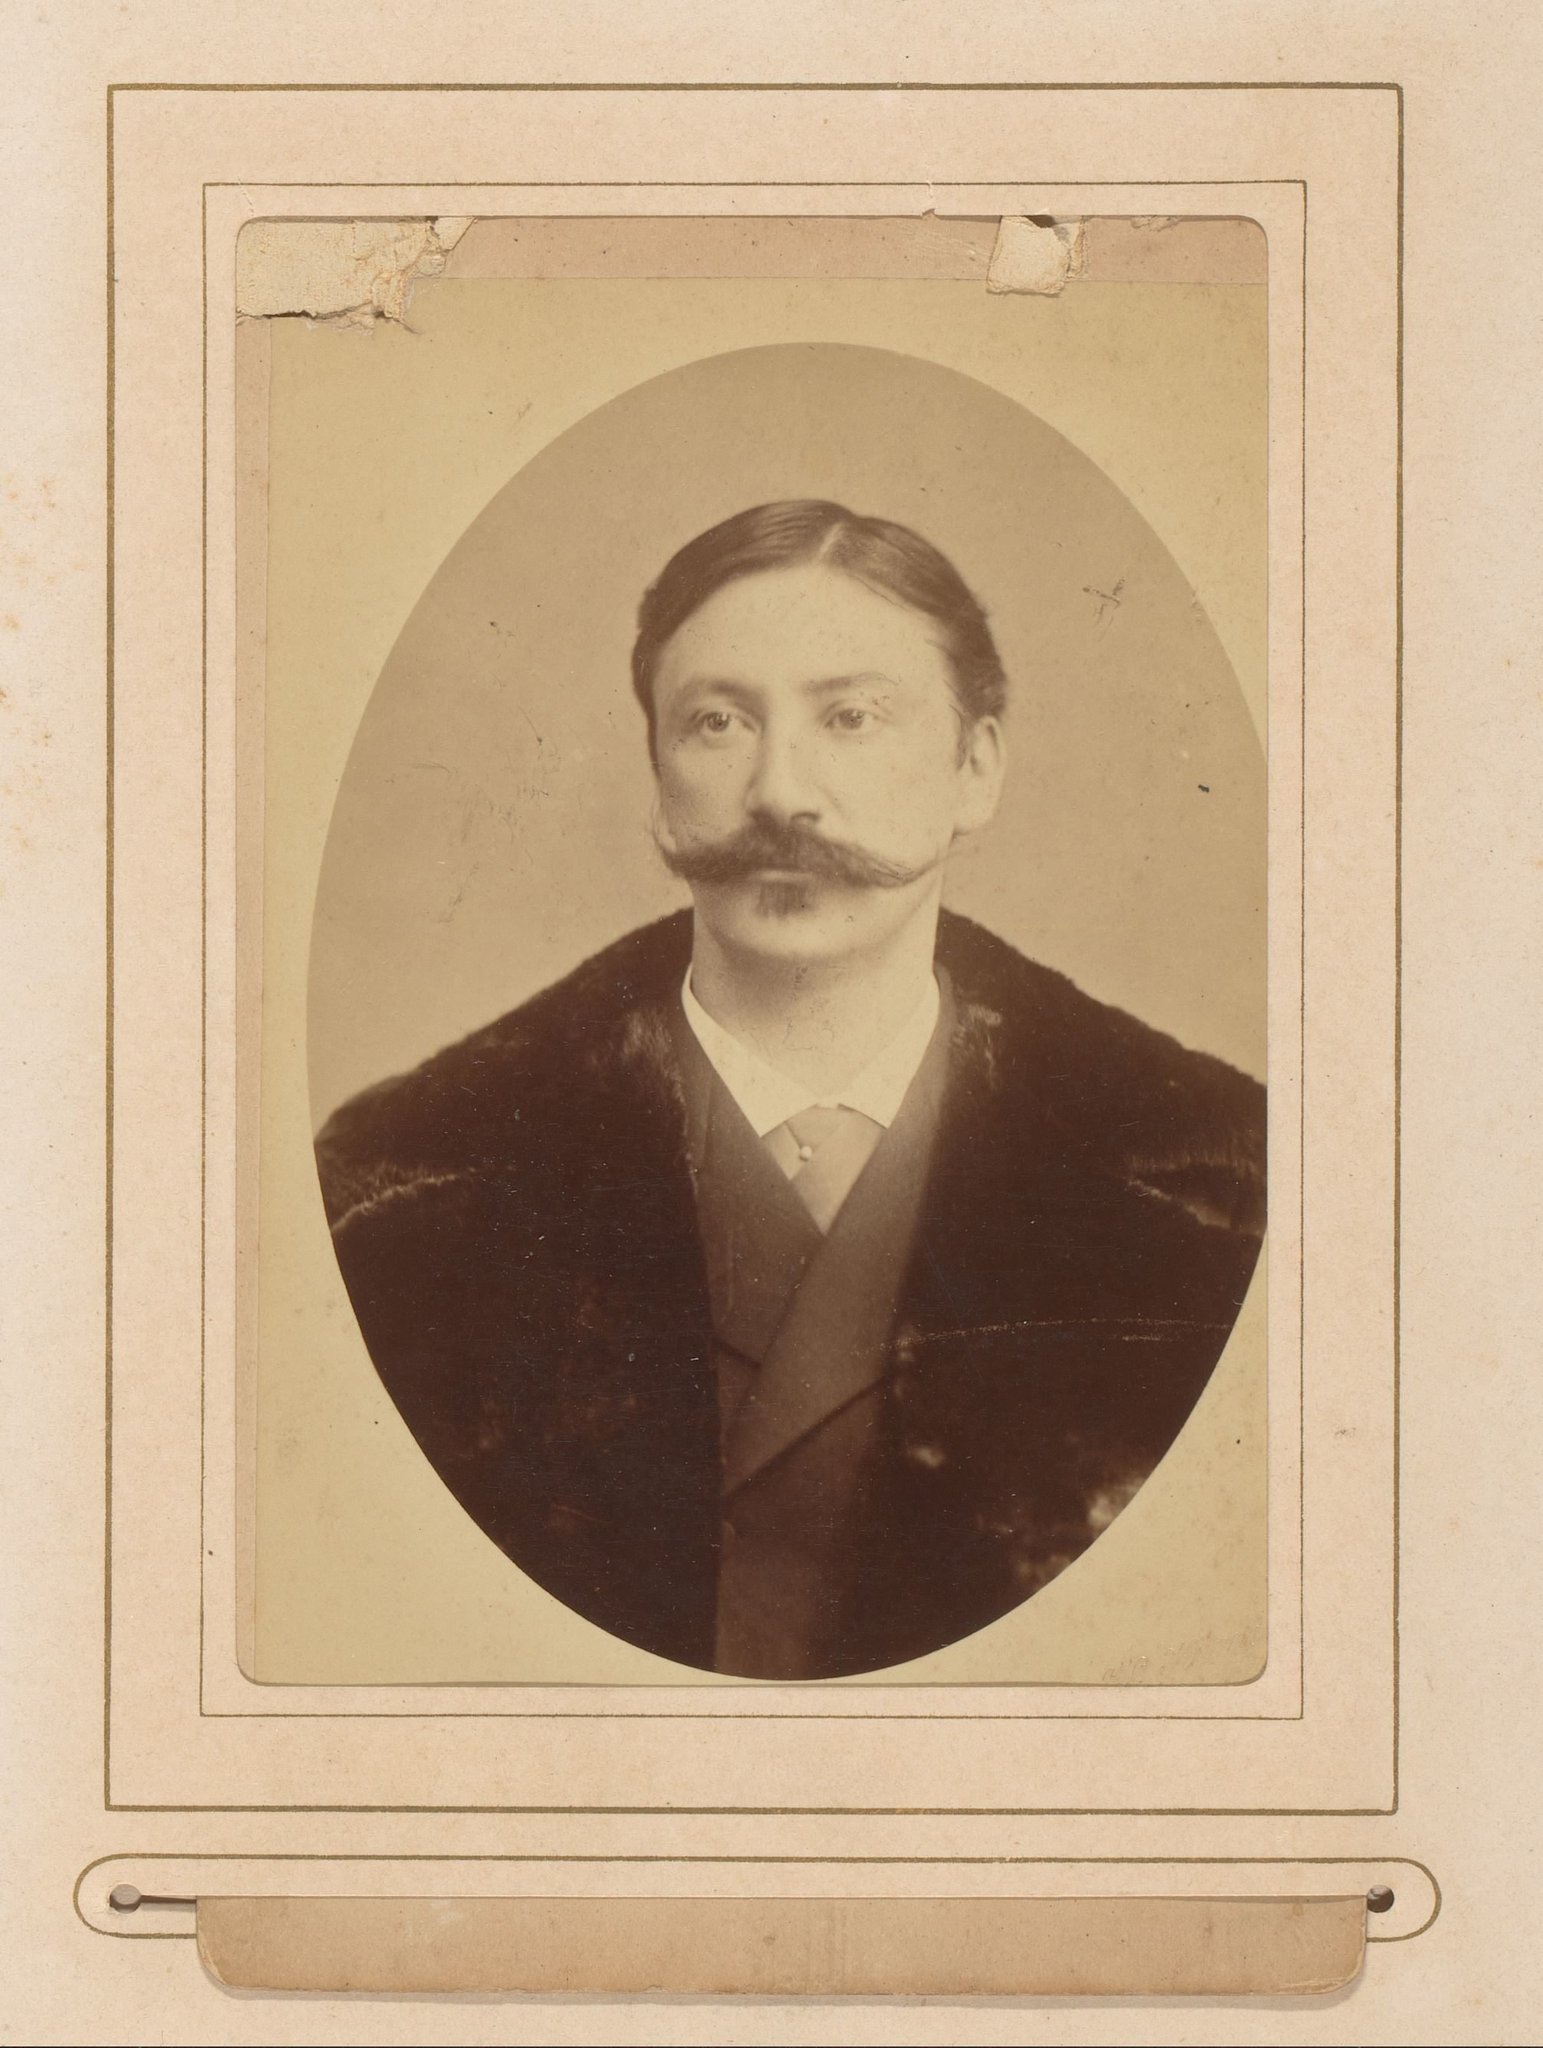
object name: cabinet photograph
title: Portret van een man met snor, aangeduid als Edouard Donker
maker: wilhelm küpper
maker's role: fotograaf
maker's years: 1838-1892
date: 1884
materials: cardboard, photographic support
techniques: albumen print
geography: utrecht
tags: moustache, historical persons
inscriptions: inscription: ‘Wilh. Küppers/ Photogr. Artist/ Utrecht’, annotation: ‘Souvenir Sympathigue/ à Gertrude Donkers/ Edouard Donkers/ Utrecht 12 Mars 1884’